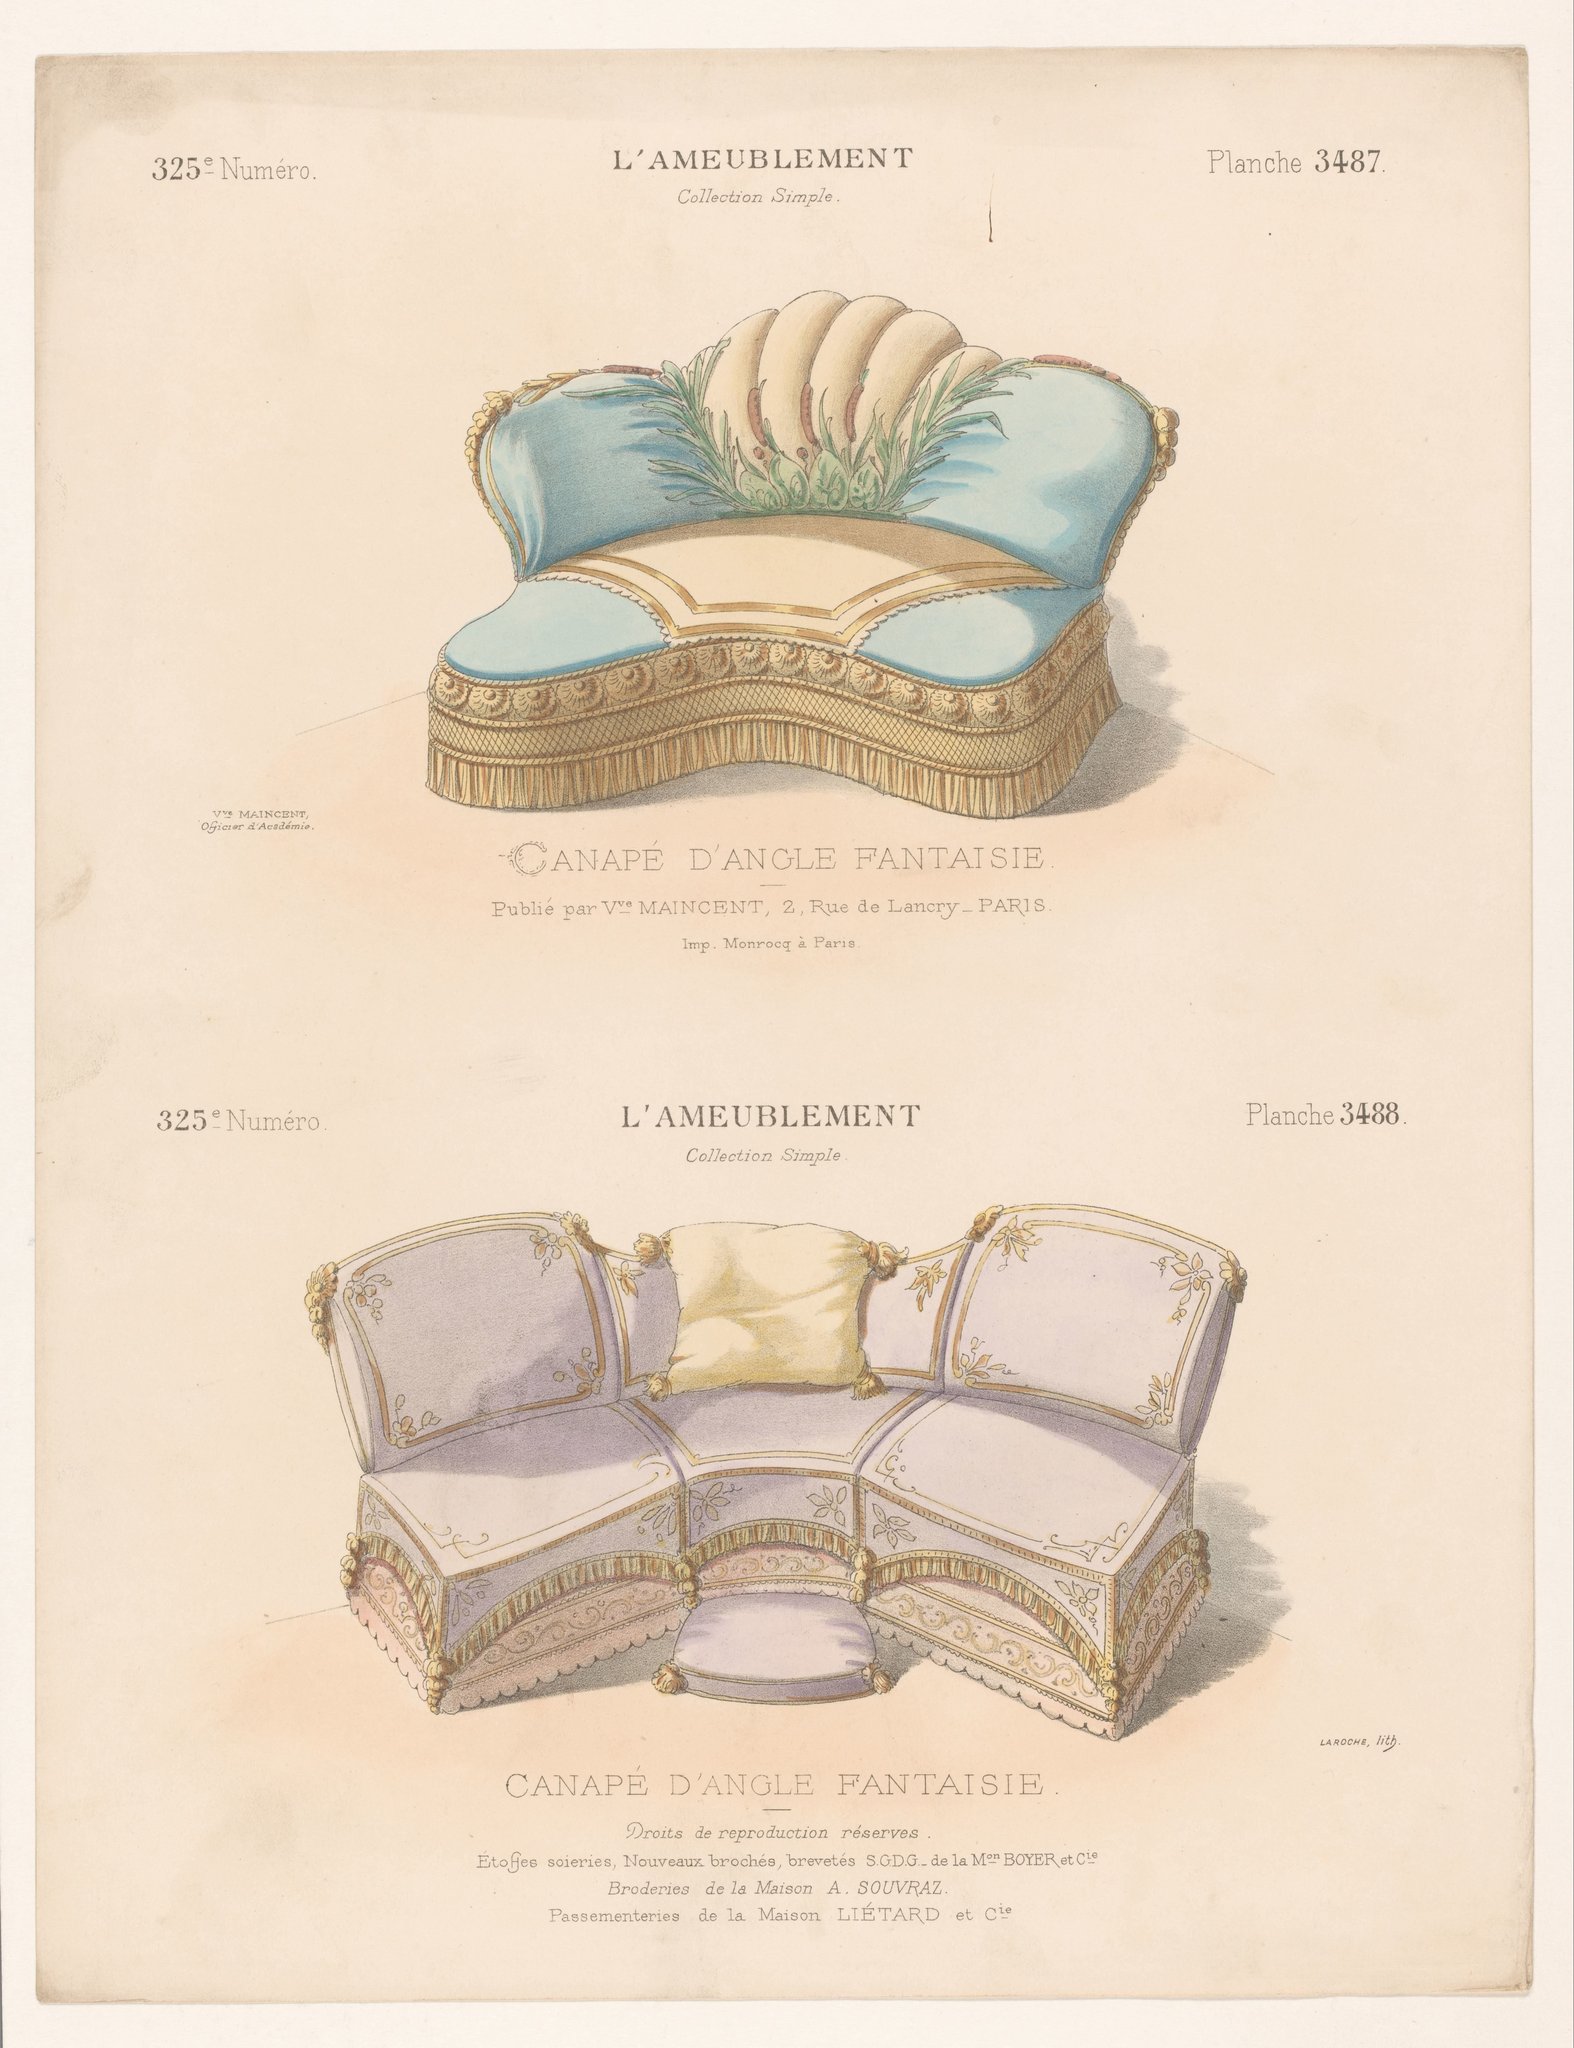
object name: print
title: L'ameublement / Collection simple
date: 1895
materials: paper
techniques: hand coloring, lithograph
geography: paris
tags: seating furniture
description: Twee canapés. Prent uit 325e nummer (livraison).